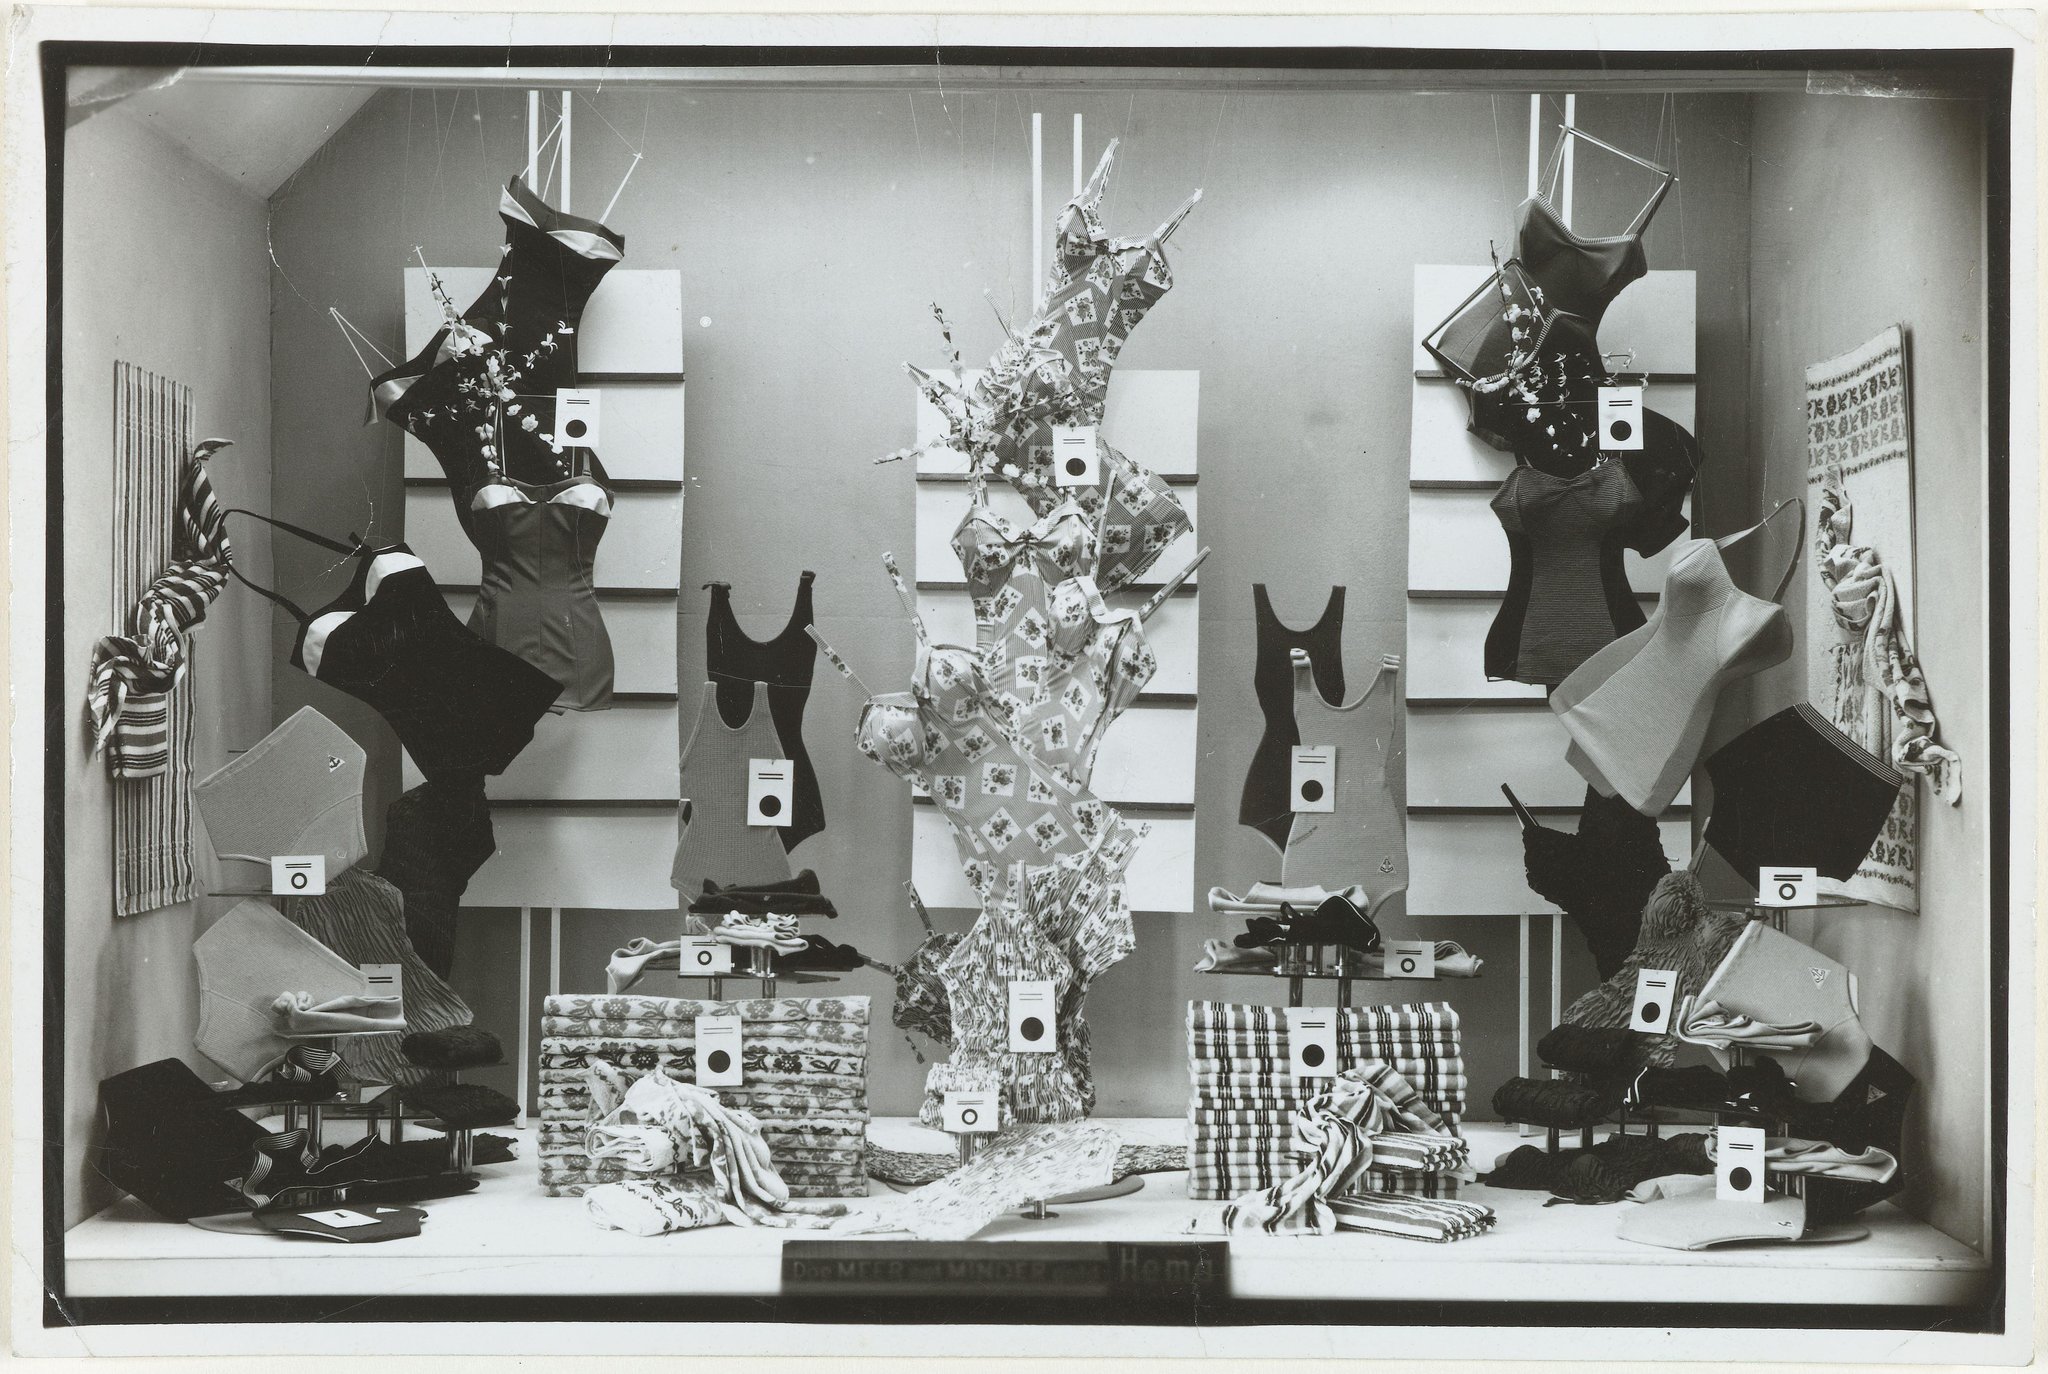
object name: photograph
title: Etalage van de Hema met badmode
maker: Anonymous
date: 1950-1960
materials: photographic support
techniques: photography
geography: netherlands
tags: shop-window, show-window, netherlands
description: Etalagepresentatie van de Hema met badpakken, herenzwembroeken en badlakens. Deze foto behoort tot een serie van 13 foto's van etalages van de Hema uit de jaren vijftig.